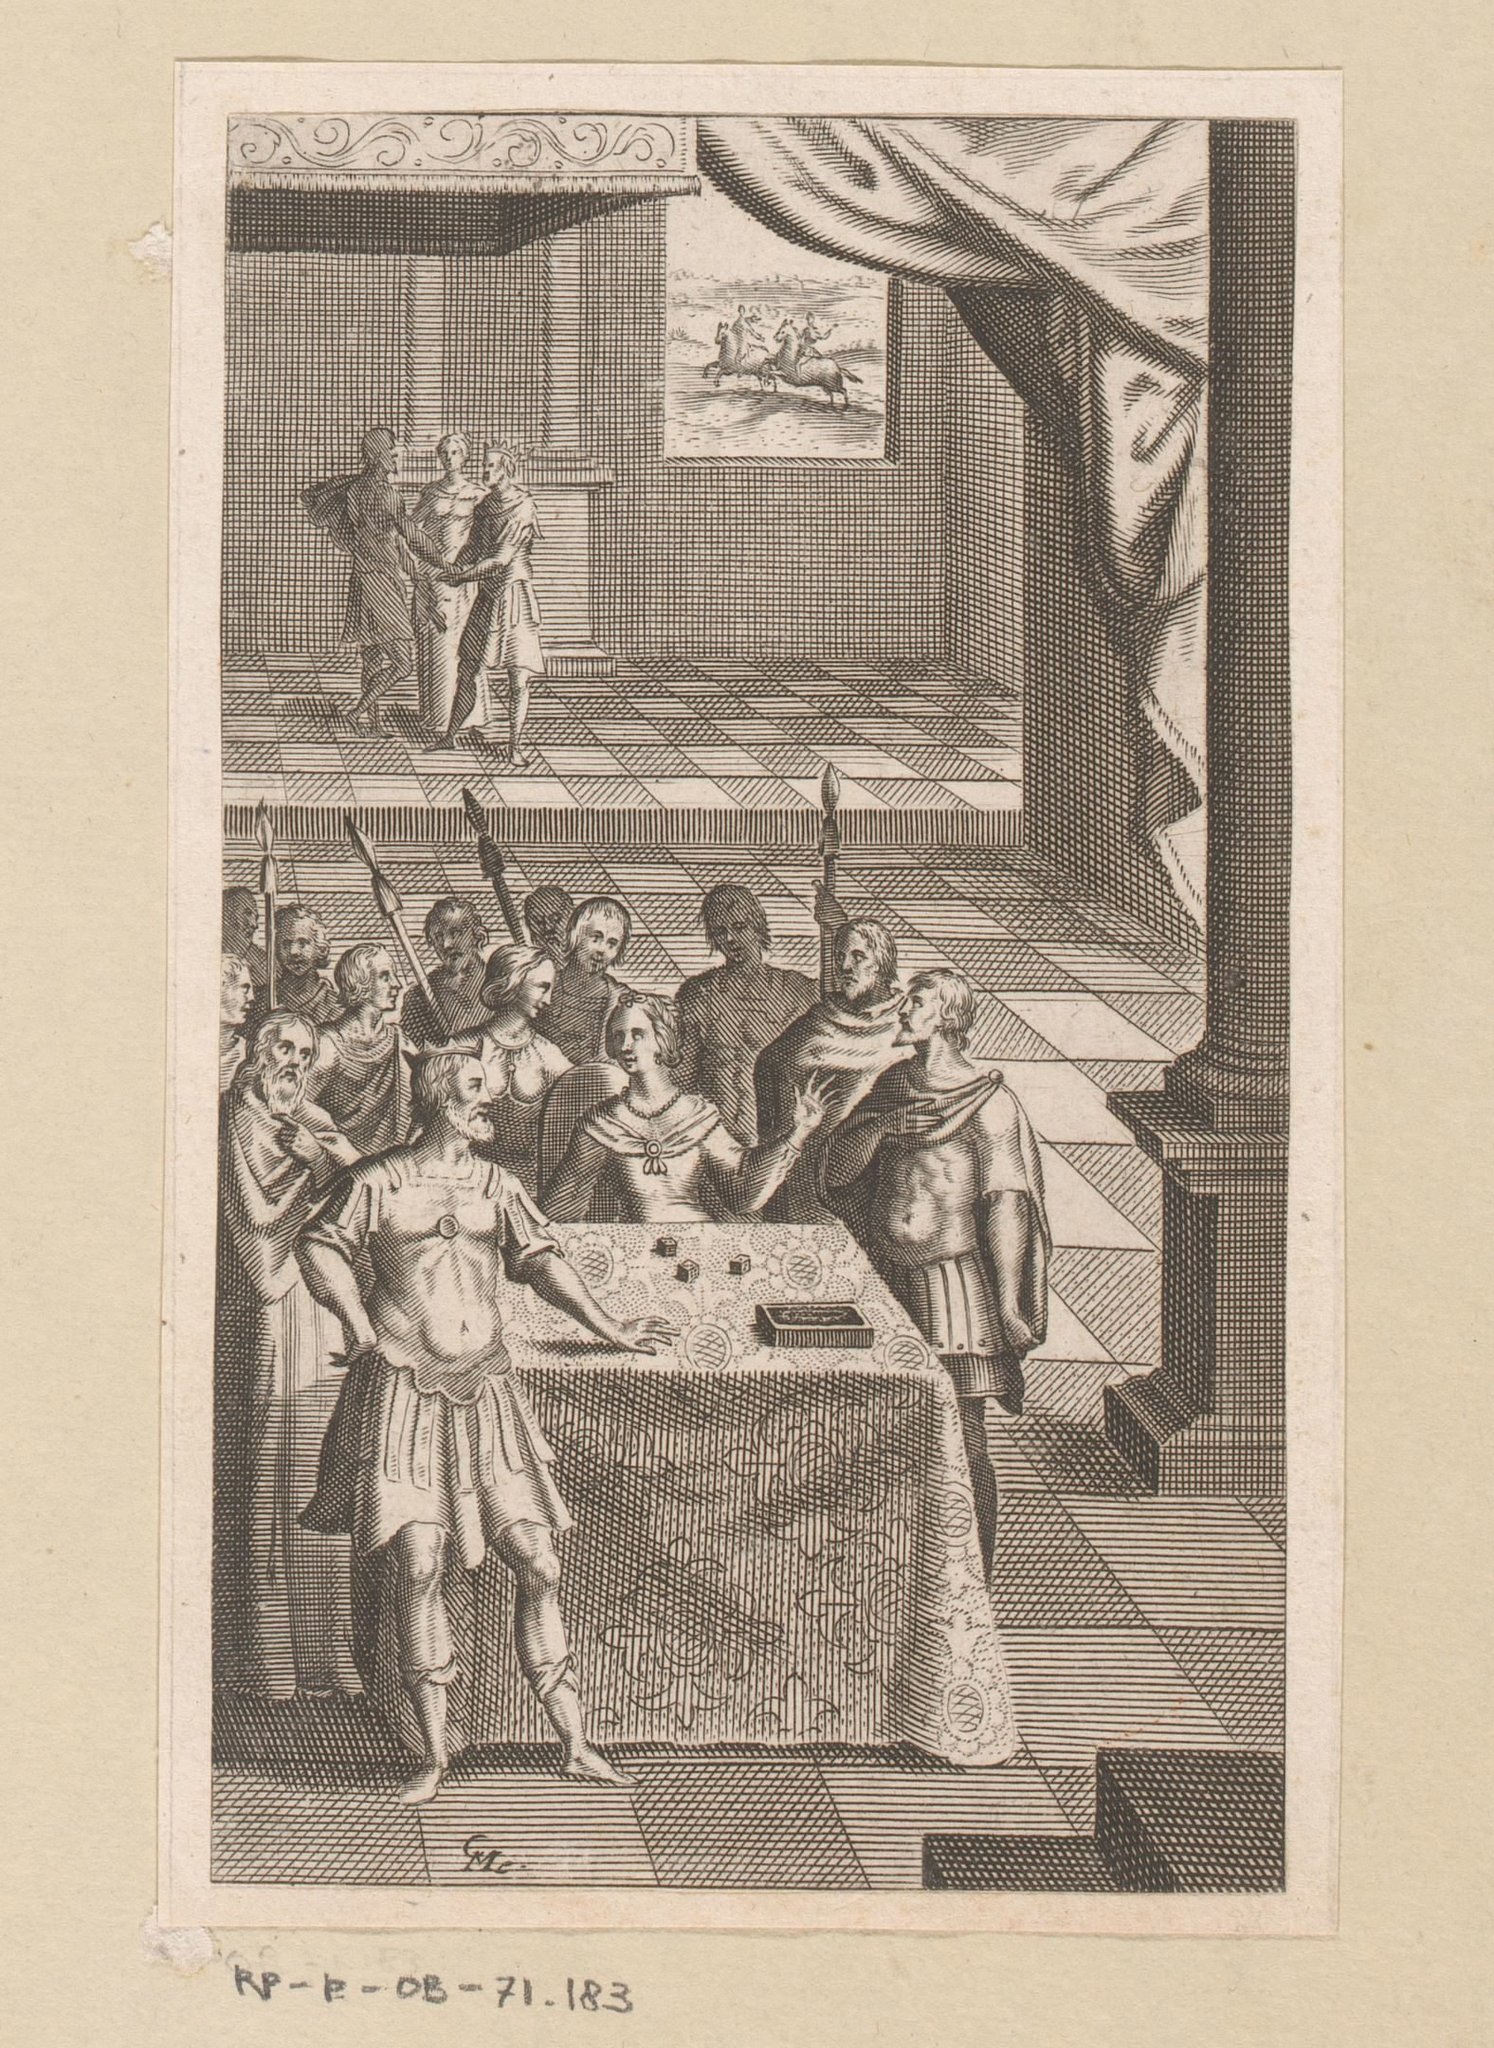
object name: print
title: Koning Meleander dobbelt met zijn dochter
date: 1624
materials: paper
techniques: engraving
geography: paris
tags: dice-games, king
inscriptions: collector's mark: Lugt 240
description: Prent uit: Barclay, Jean. L'Argenis. Traduction nouvelle enrichie de figures. Parijs: Nicolas Buon, 1624, dl. 2, hoofdstuk 6. In 1625 werd een tweede editie uitgegeven, eveneens door Nicolas Buon en in 1636 werd een Engelse vertaling uitgegeven door Henry Seile in Londen.